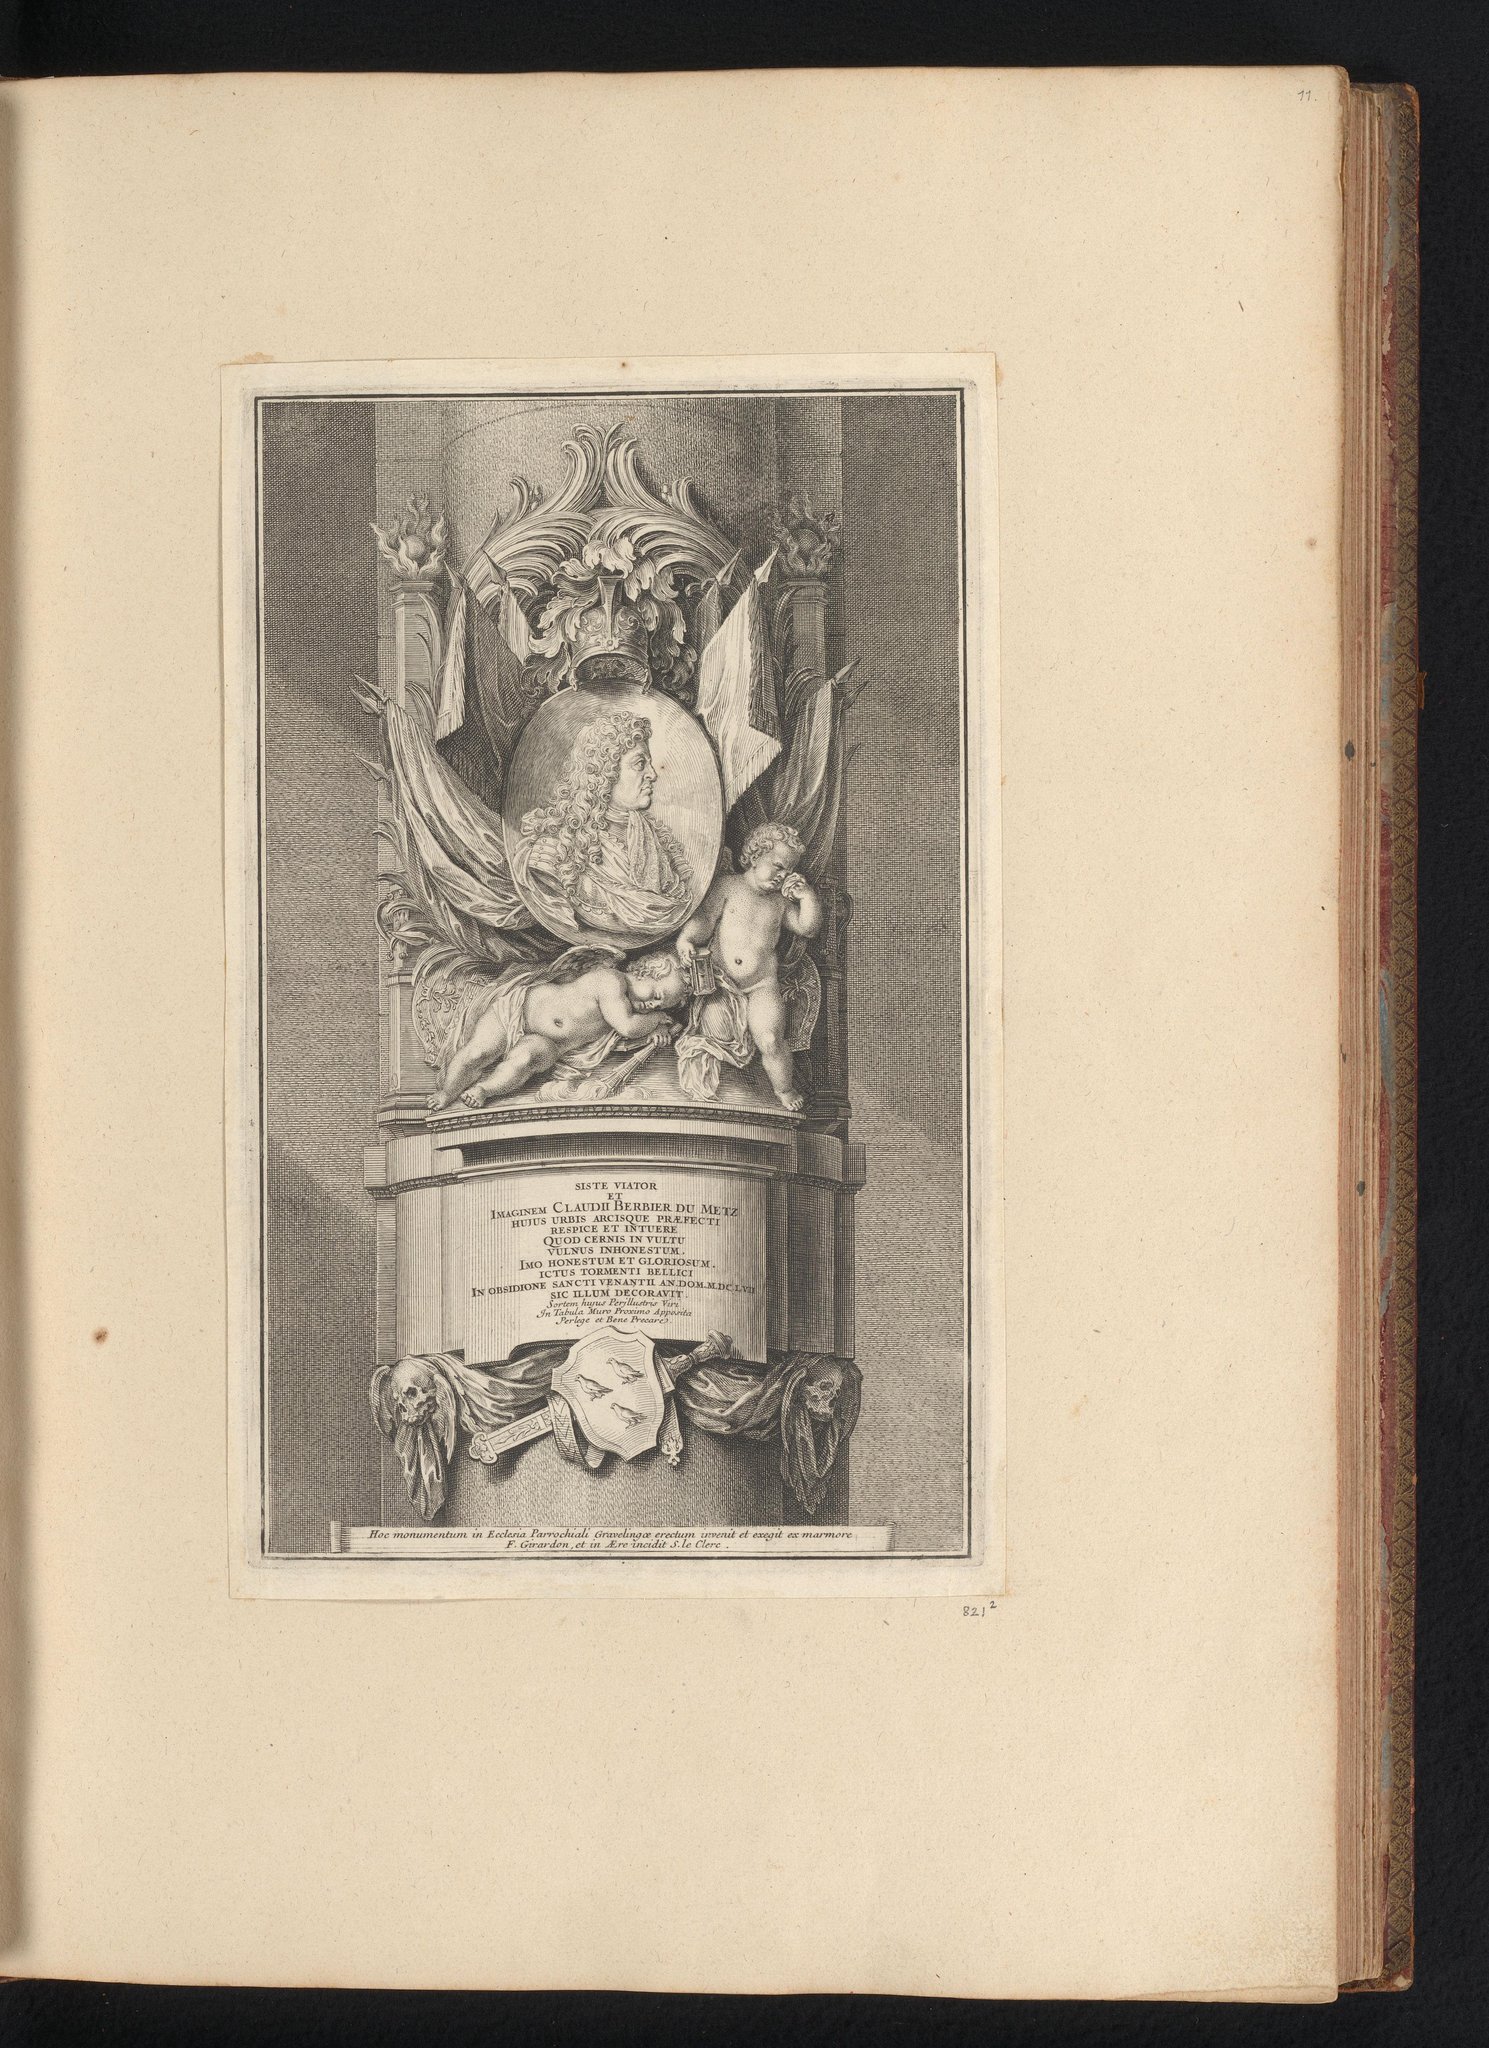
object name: album leaf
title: Grafmonument van Claude Berbier du Metz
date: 1692-1693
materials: paper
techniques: etching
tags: gravestone, tombstone